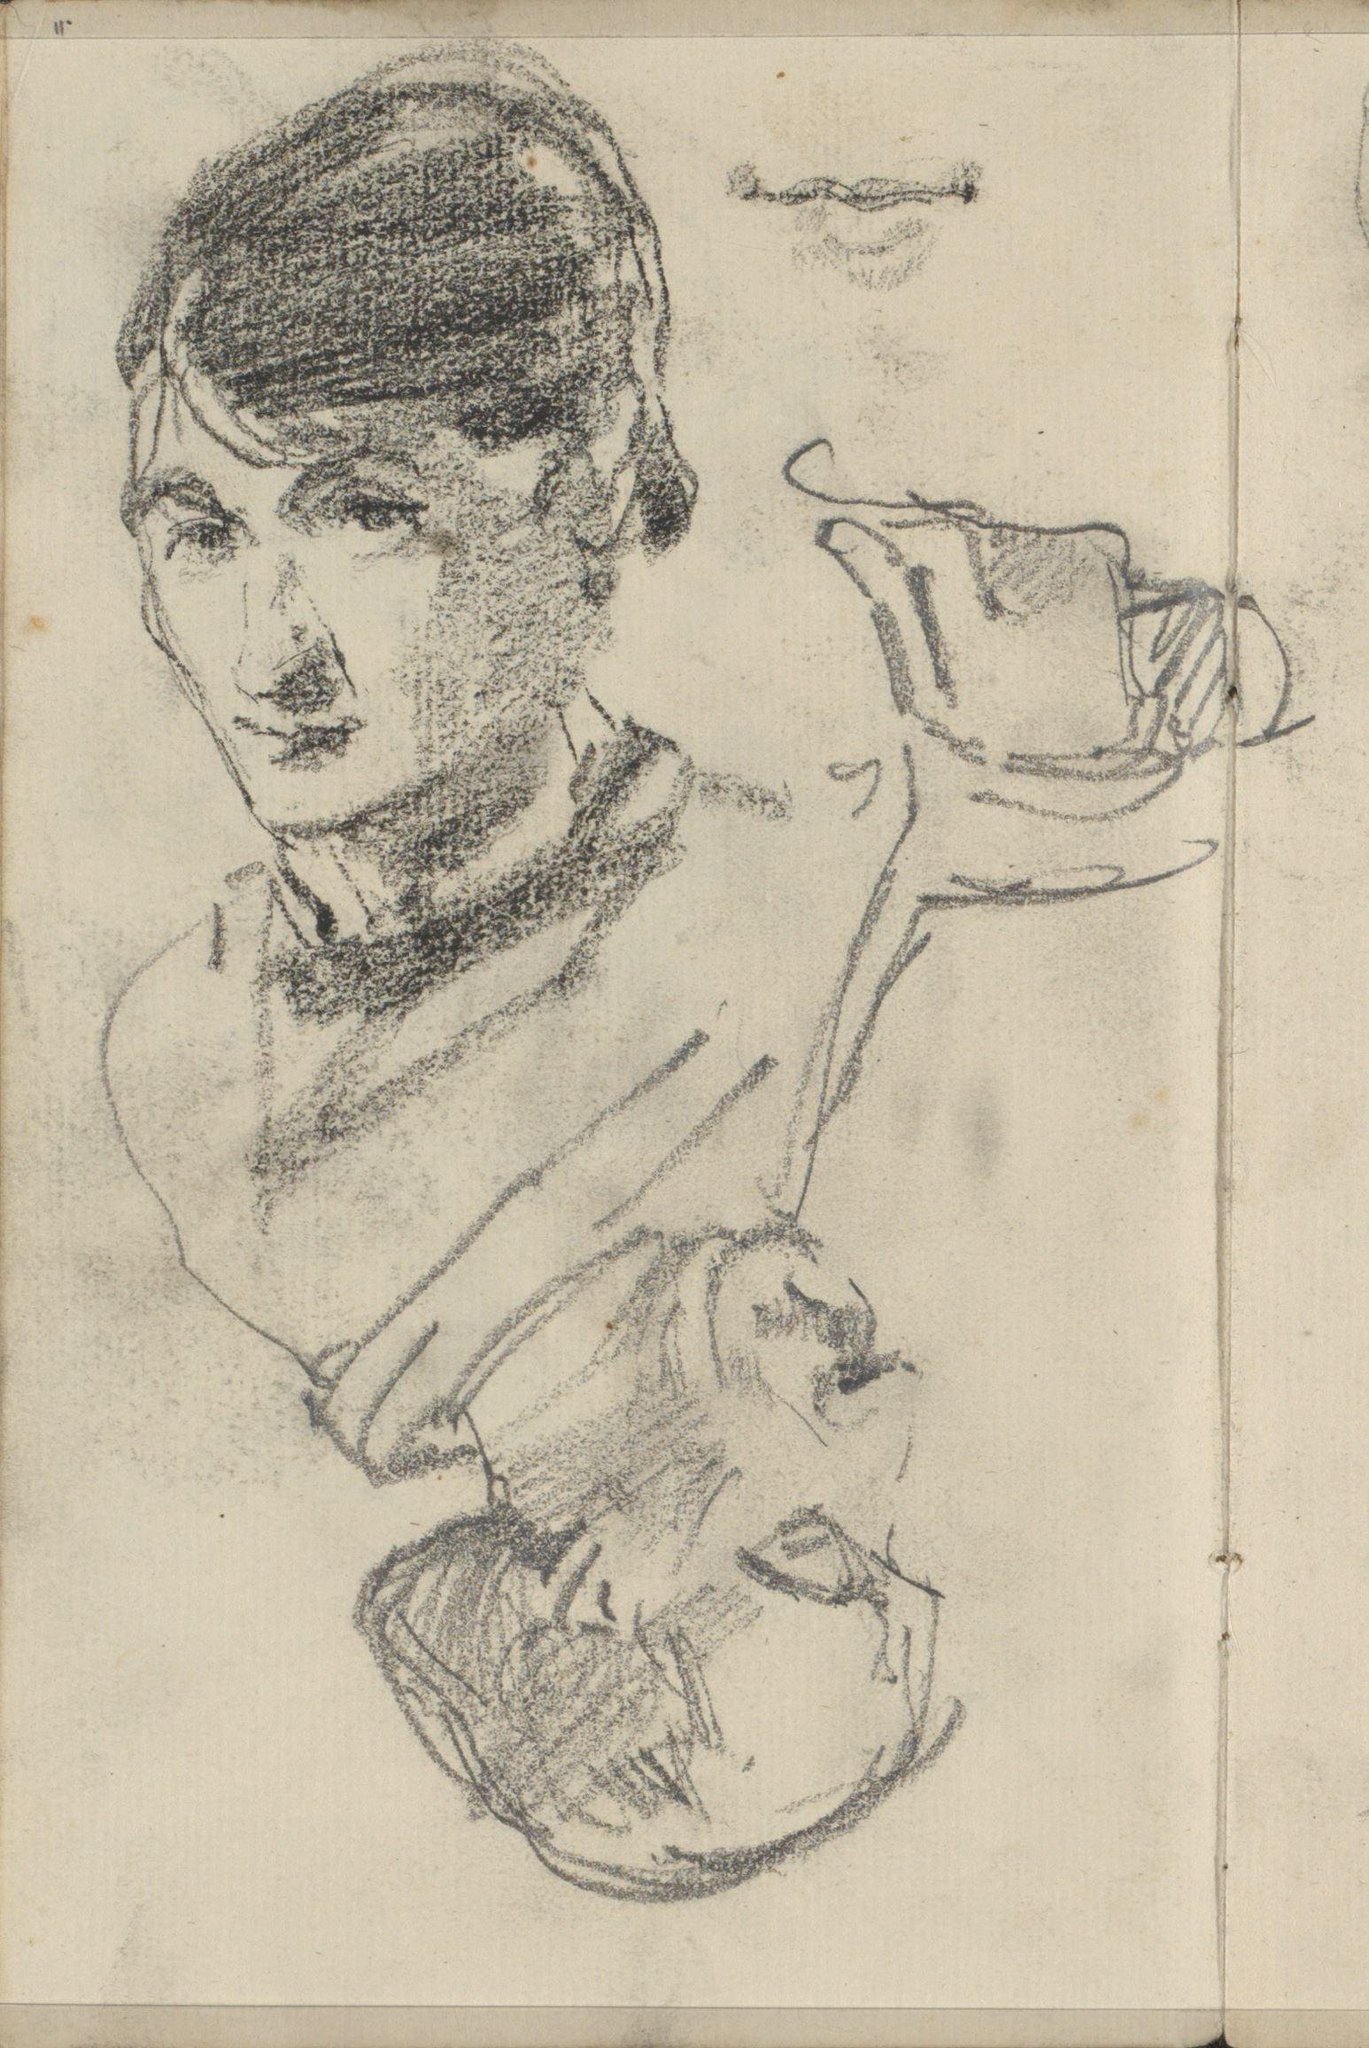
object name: sketchbook leaf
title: Twee mannenhoofden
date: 1882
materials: chalk, paper, pencil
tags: head (human) (+ left side visible; left - (l. hand, l. foot, etc.)), head (human) (+ three-quarter view)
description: Pagina 11 uit een schetsboek met 31 bladen vervaardigd te Den Haag en Rotterdam.